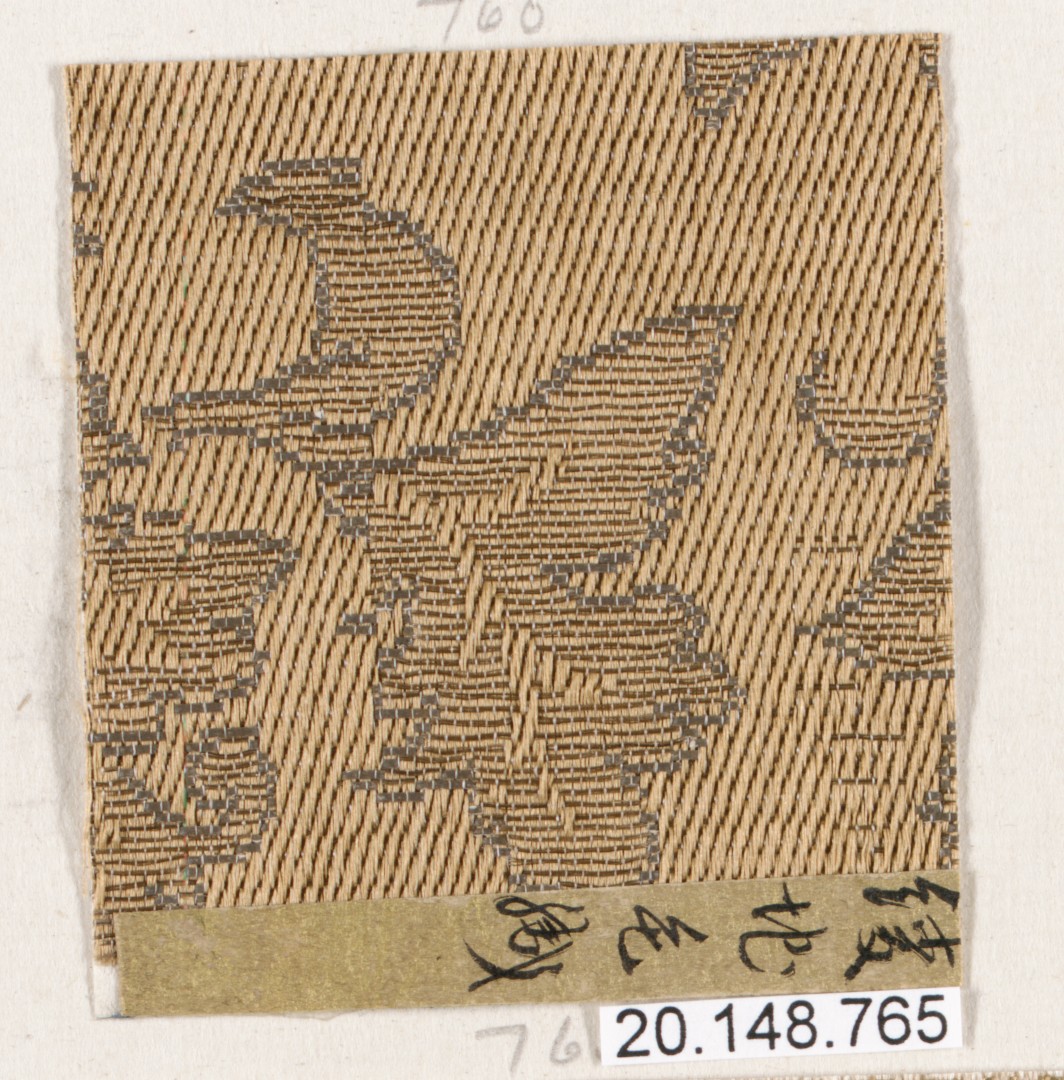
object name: piece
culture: japanese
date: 1601-1700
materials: silk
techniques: compound weave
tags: leaves